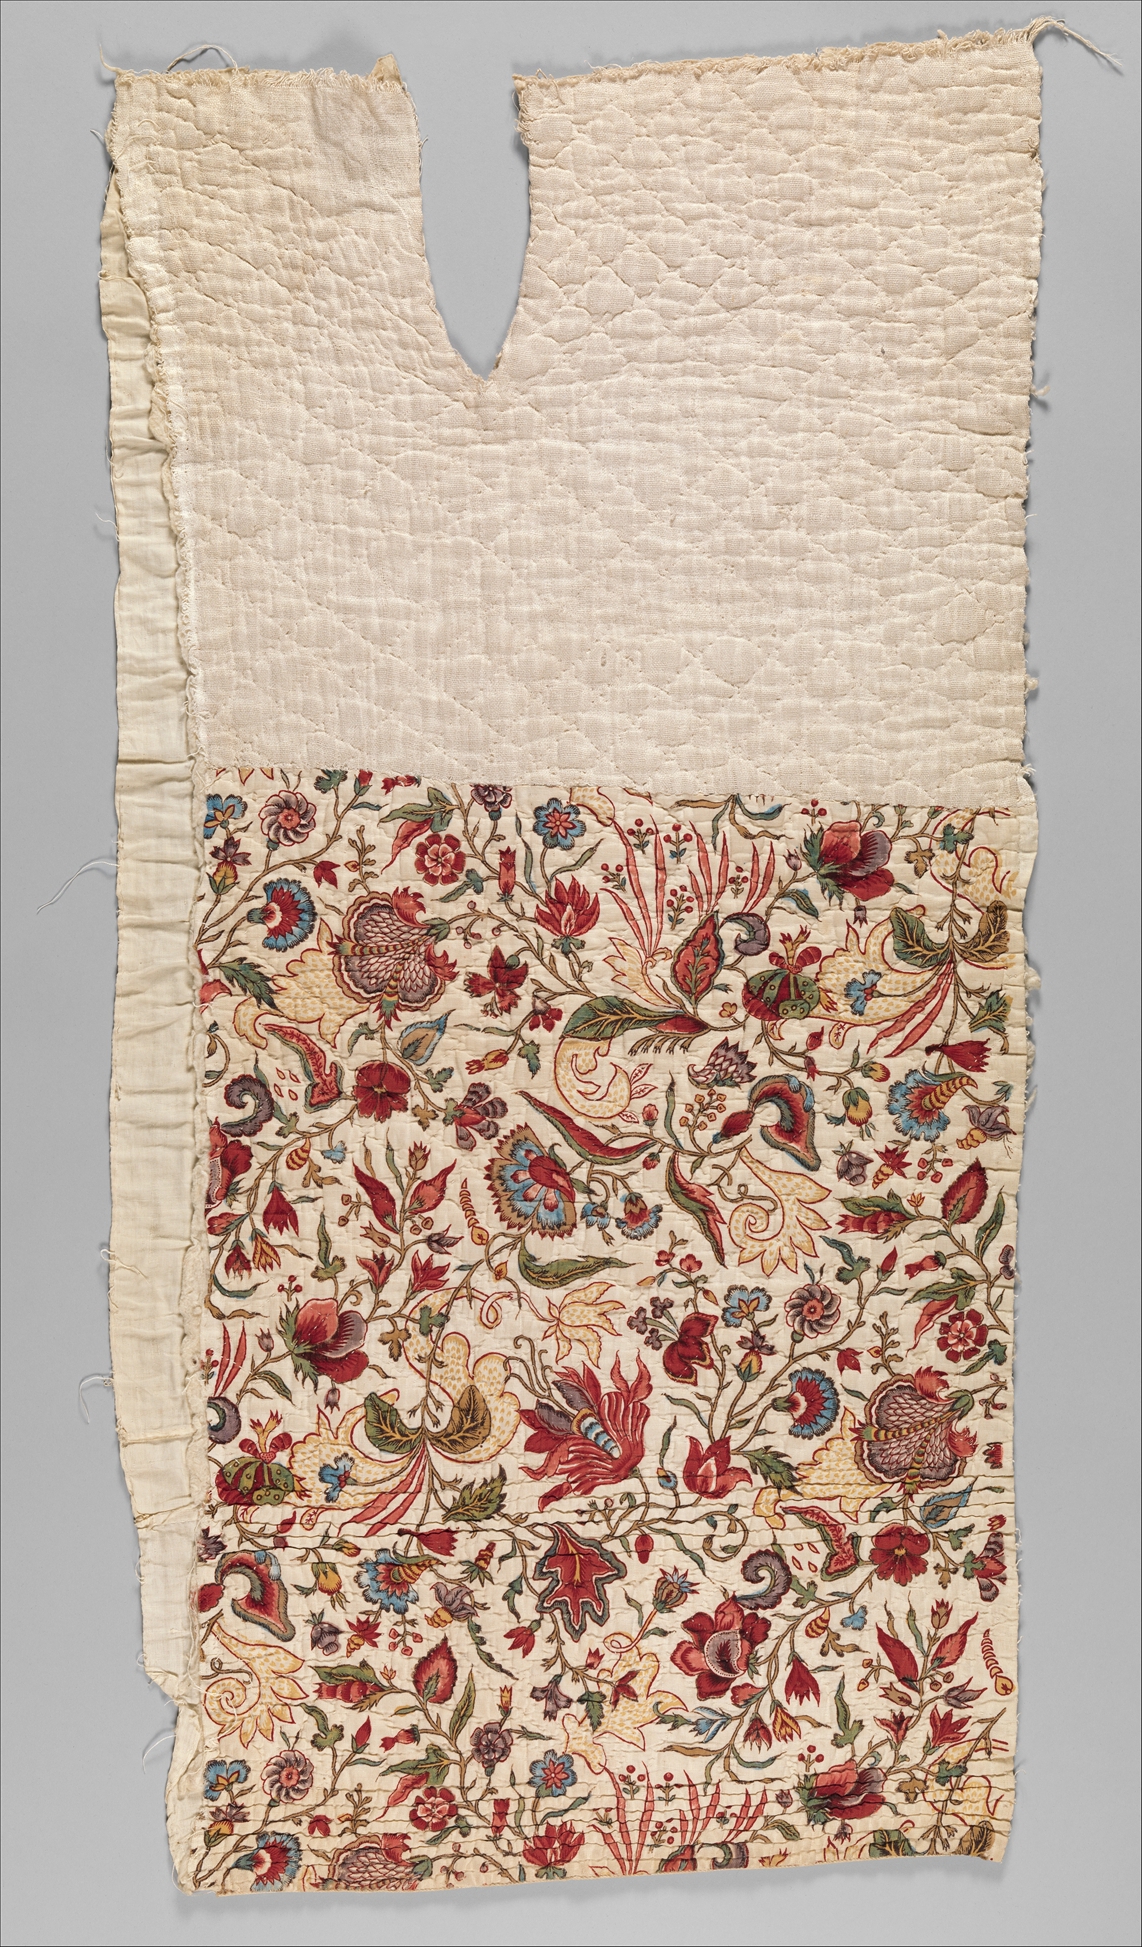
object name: fragment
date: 1775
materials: cotton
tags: flowers,leaves